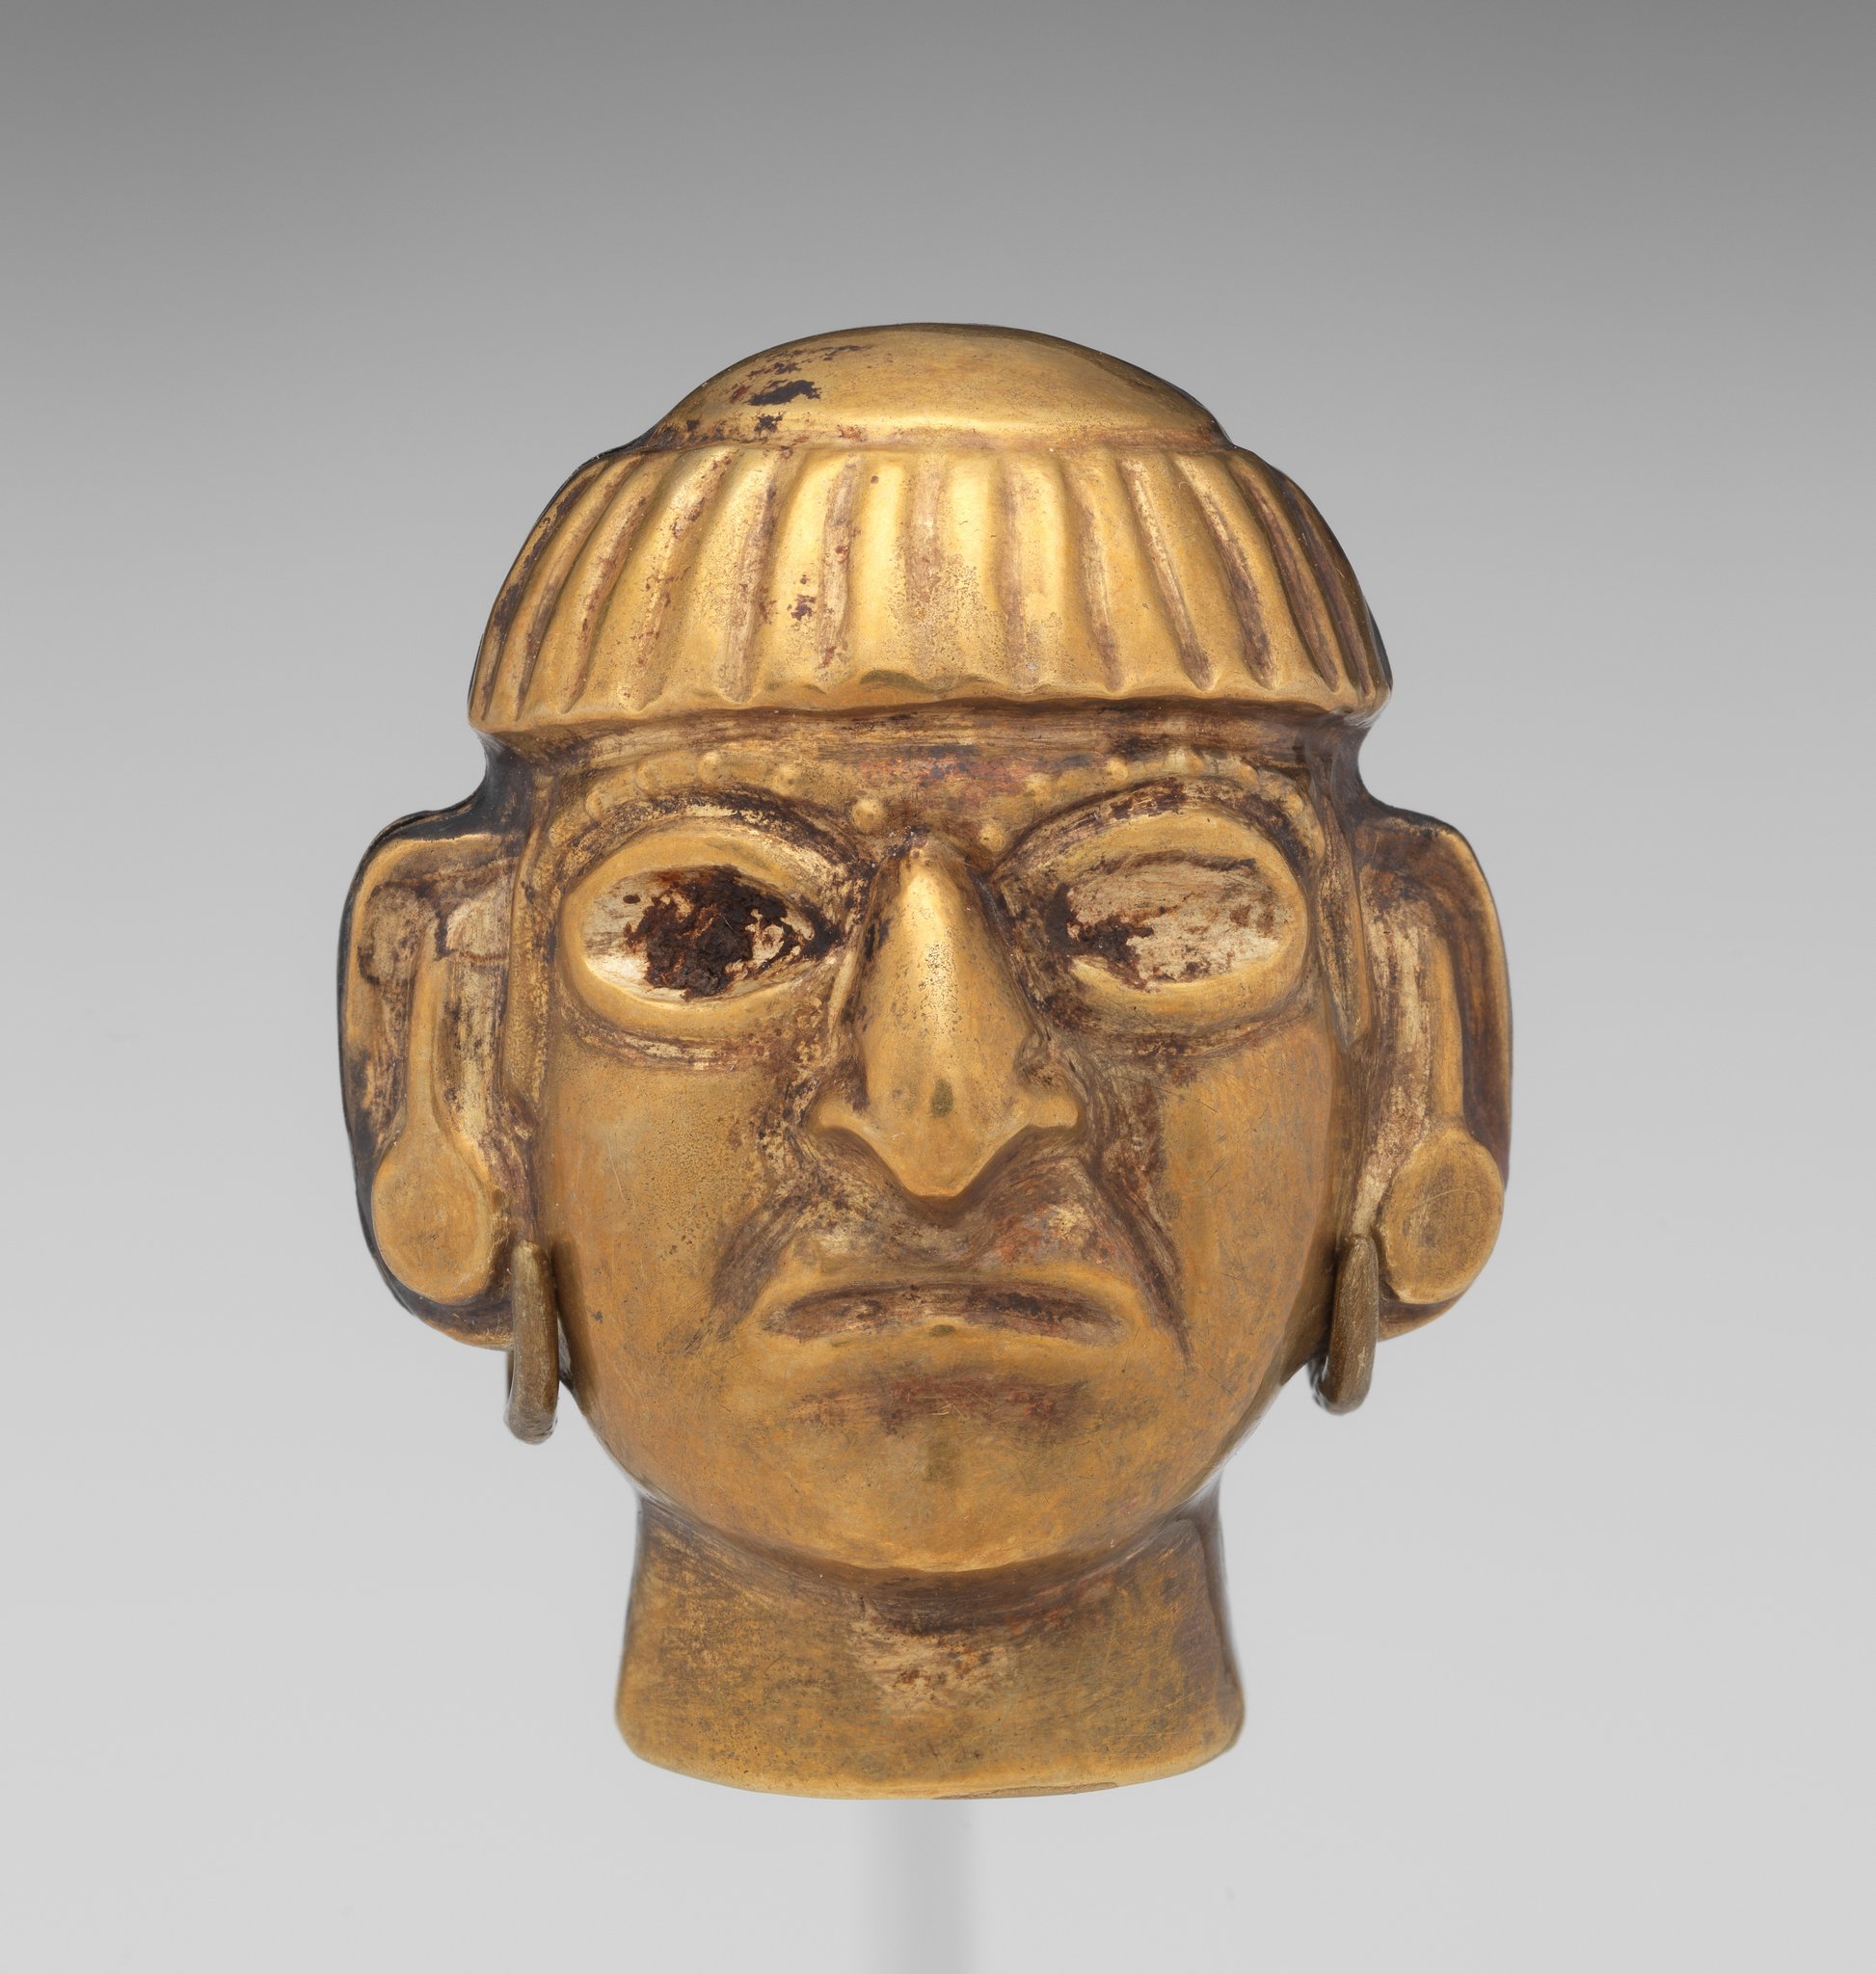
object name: bead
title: Head-shaped bead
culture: moche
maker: moche artist(s)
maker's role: artist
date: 200-800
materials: gold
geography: peru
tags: heads